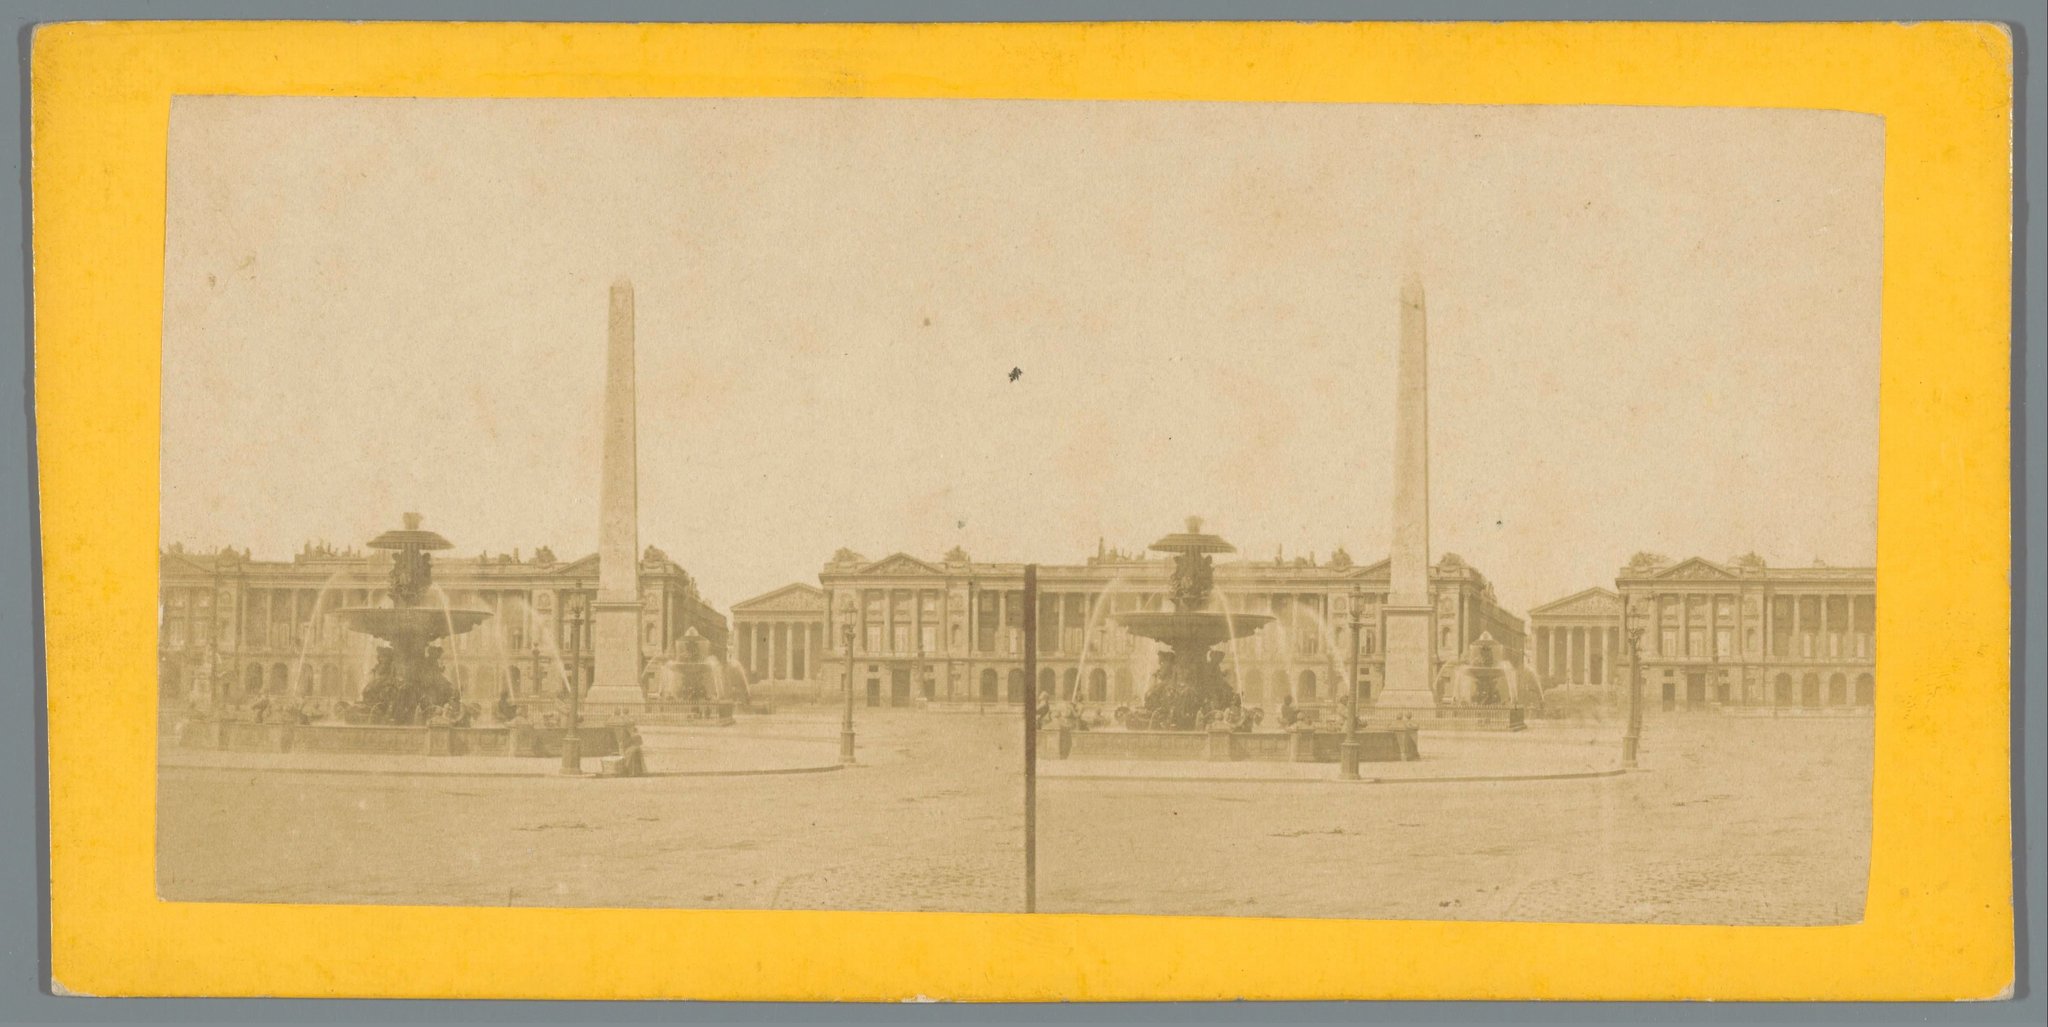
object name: stereograph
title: Gezicht op Place de la Concorde in Parijs met een fontein en de Luxor obelisk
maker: Anonymous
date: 1850-1880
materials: cardboard, photographic support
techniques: albumen print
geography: place de la concorde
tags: square, place, circus, etc., monument, statue, ornamental fountain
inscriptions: inscription: ‘Place de la Concorde, Paris’